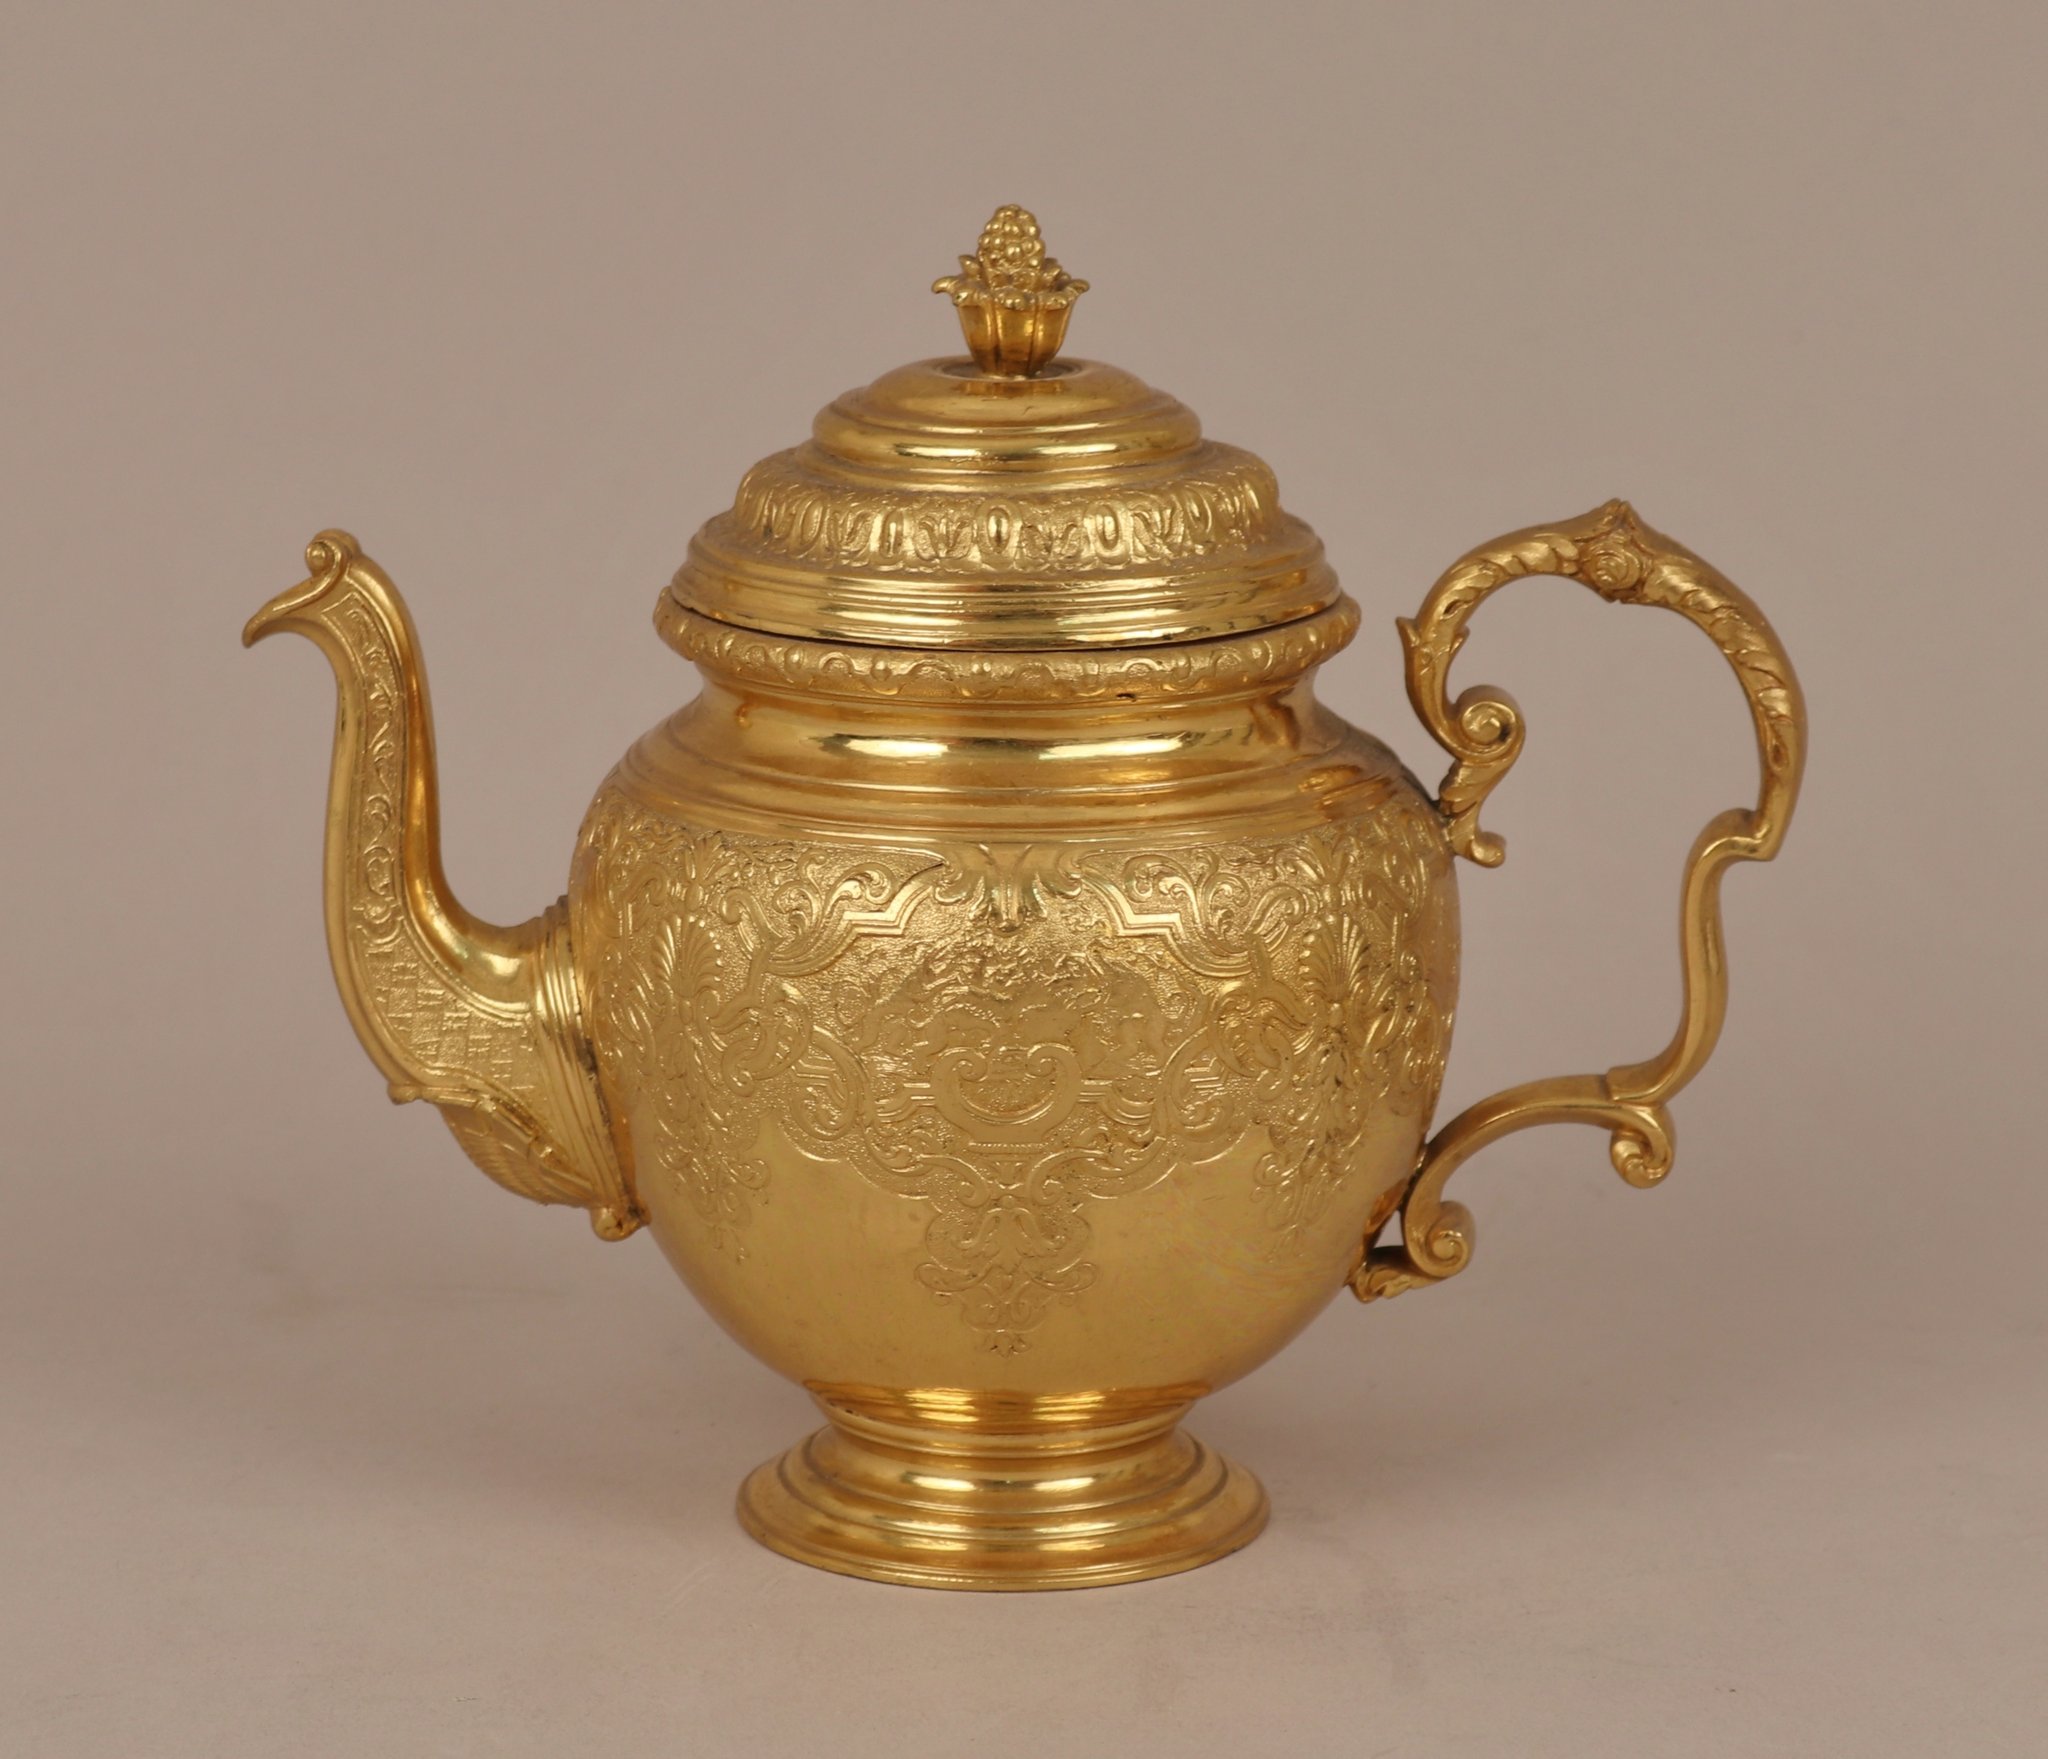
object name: teapot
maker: johann ludwig ii biller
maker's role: maker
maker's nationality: german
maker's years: 1692-1746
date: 1801-1900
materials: gold, metal